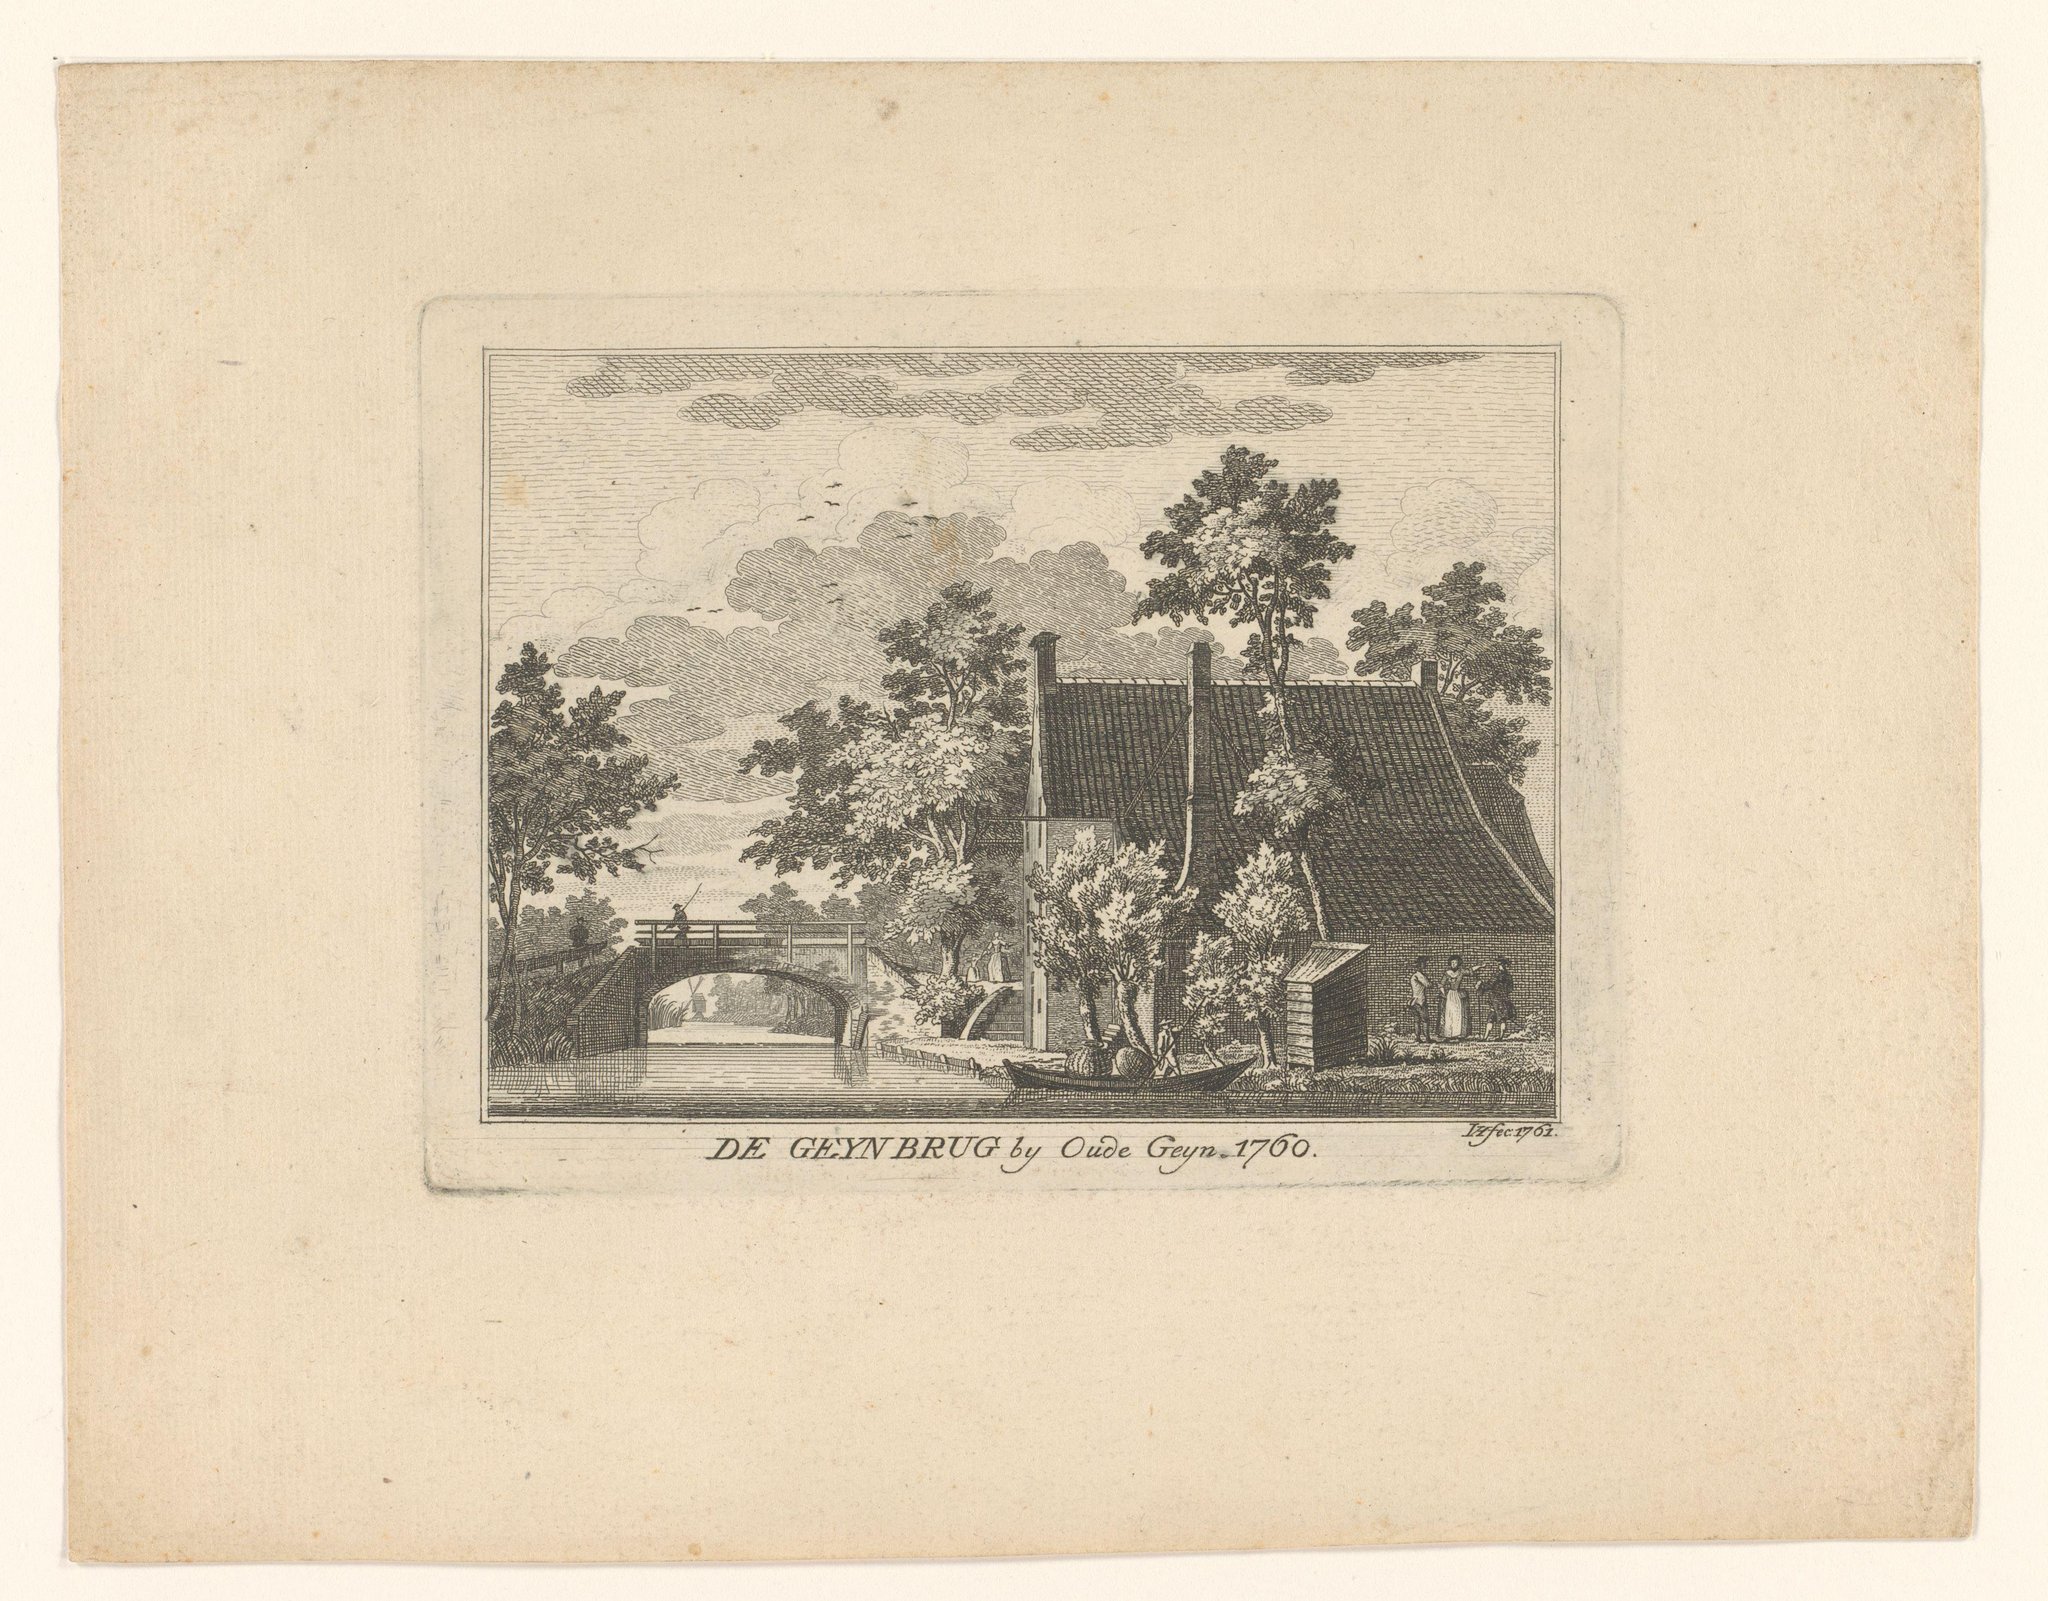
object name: print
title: Brug bij Oudegein, 1760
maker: Anonymous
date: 1761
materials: paper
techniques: etching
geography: northern netherlands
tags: bridge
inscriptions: monogram: ‘IH’